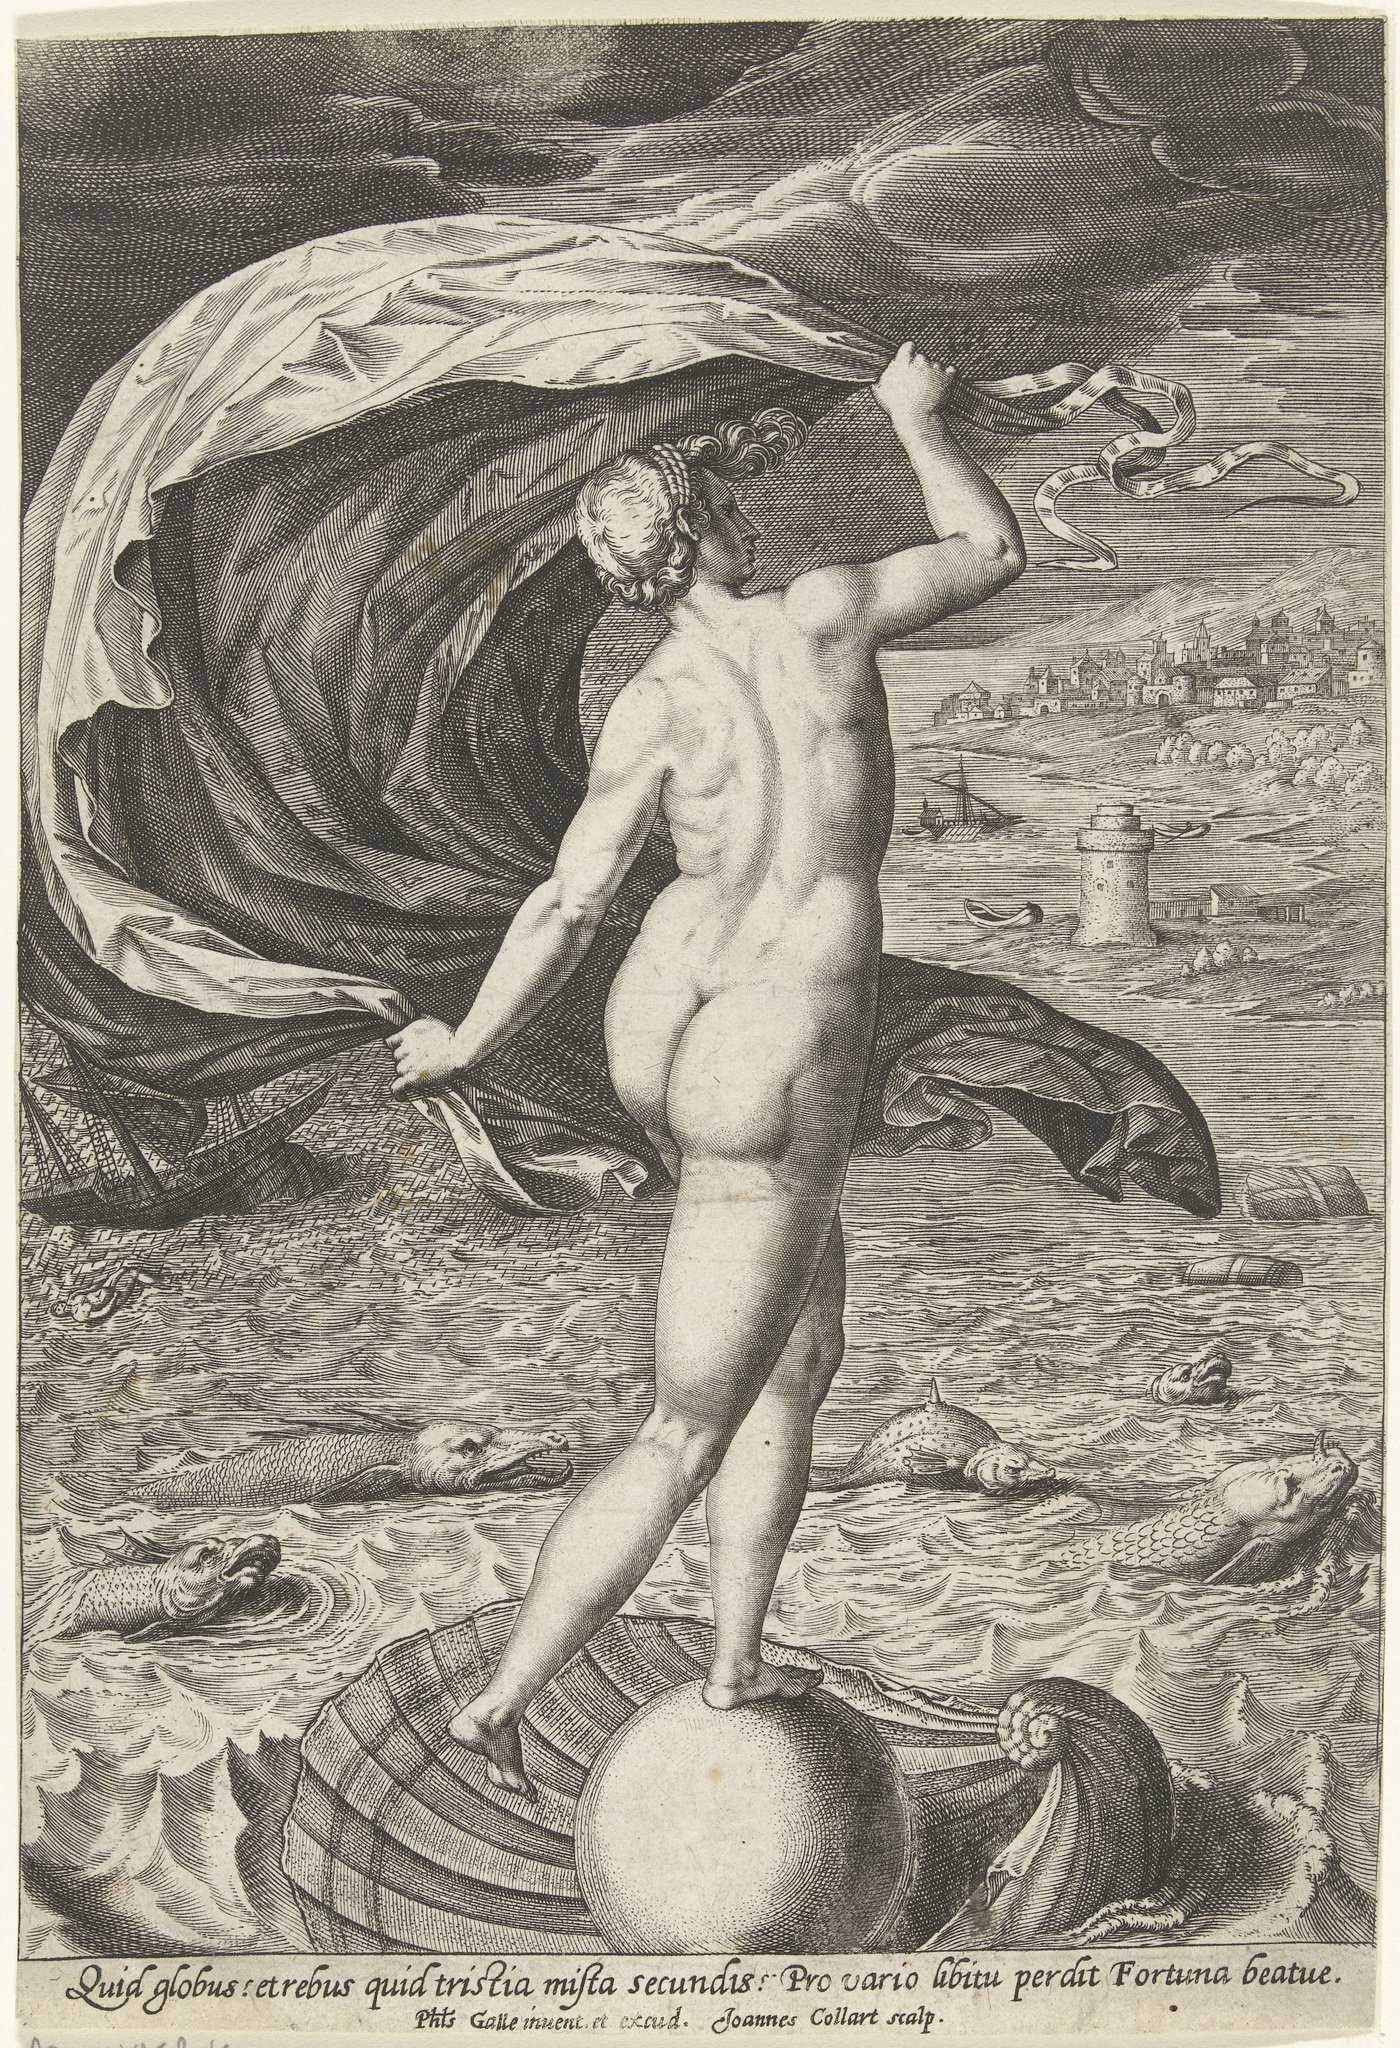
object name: print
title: Fortuin (Fortuna)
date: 1576-1628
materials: paper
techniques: engraving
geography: antwerp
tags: city-view in general; 'veduta', shipwreck, luck, fortune, lot; 'fato', 'fortuna', 'fortuna aurea', 'fortuna buona', 'fortuna pacifica overo clemente', 'sorte' (ripa)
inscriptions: collector's mark: Lugt 2760, collector's mark: Lugt 2228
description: De naakte personificatie van Fortuin of Geluk (Fortuna) vaart op een schelp over zee. Ze staat op een globe, teken van de wisselvalligheid van het geluk. Ook het bolle zeil waarmee ze over het water vaart is symbool voor deze wisselvalligheid. Rondom haar zwemmen allerlei zeemonsters en gaat een schip ten onder. In de achtergrond de contouren van een stad. De prent heeft een Latijns onderschrift.